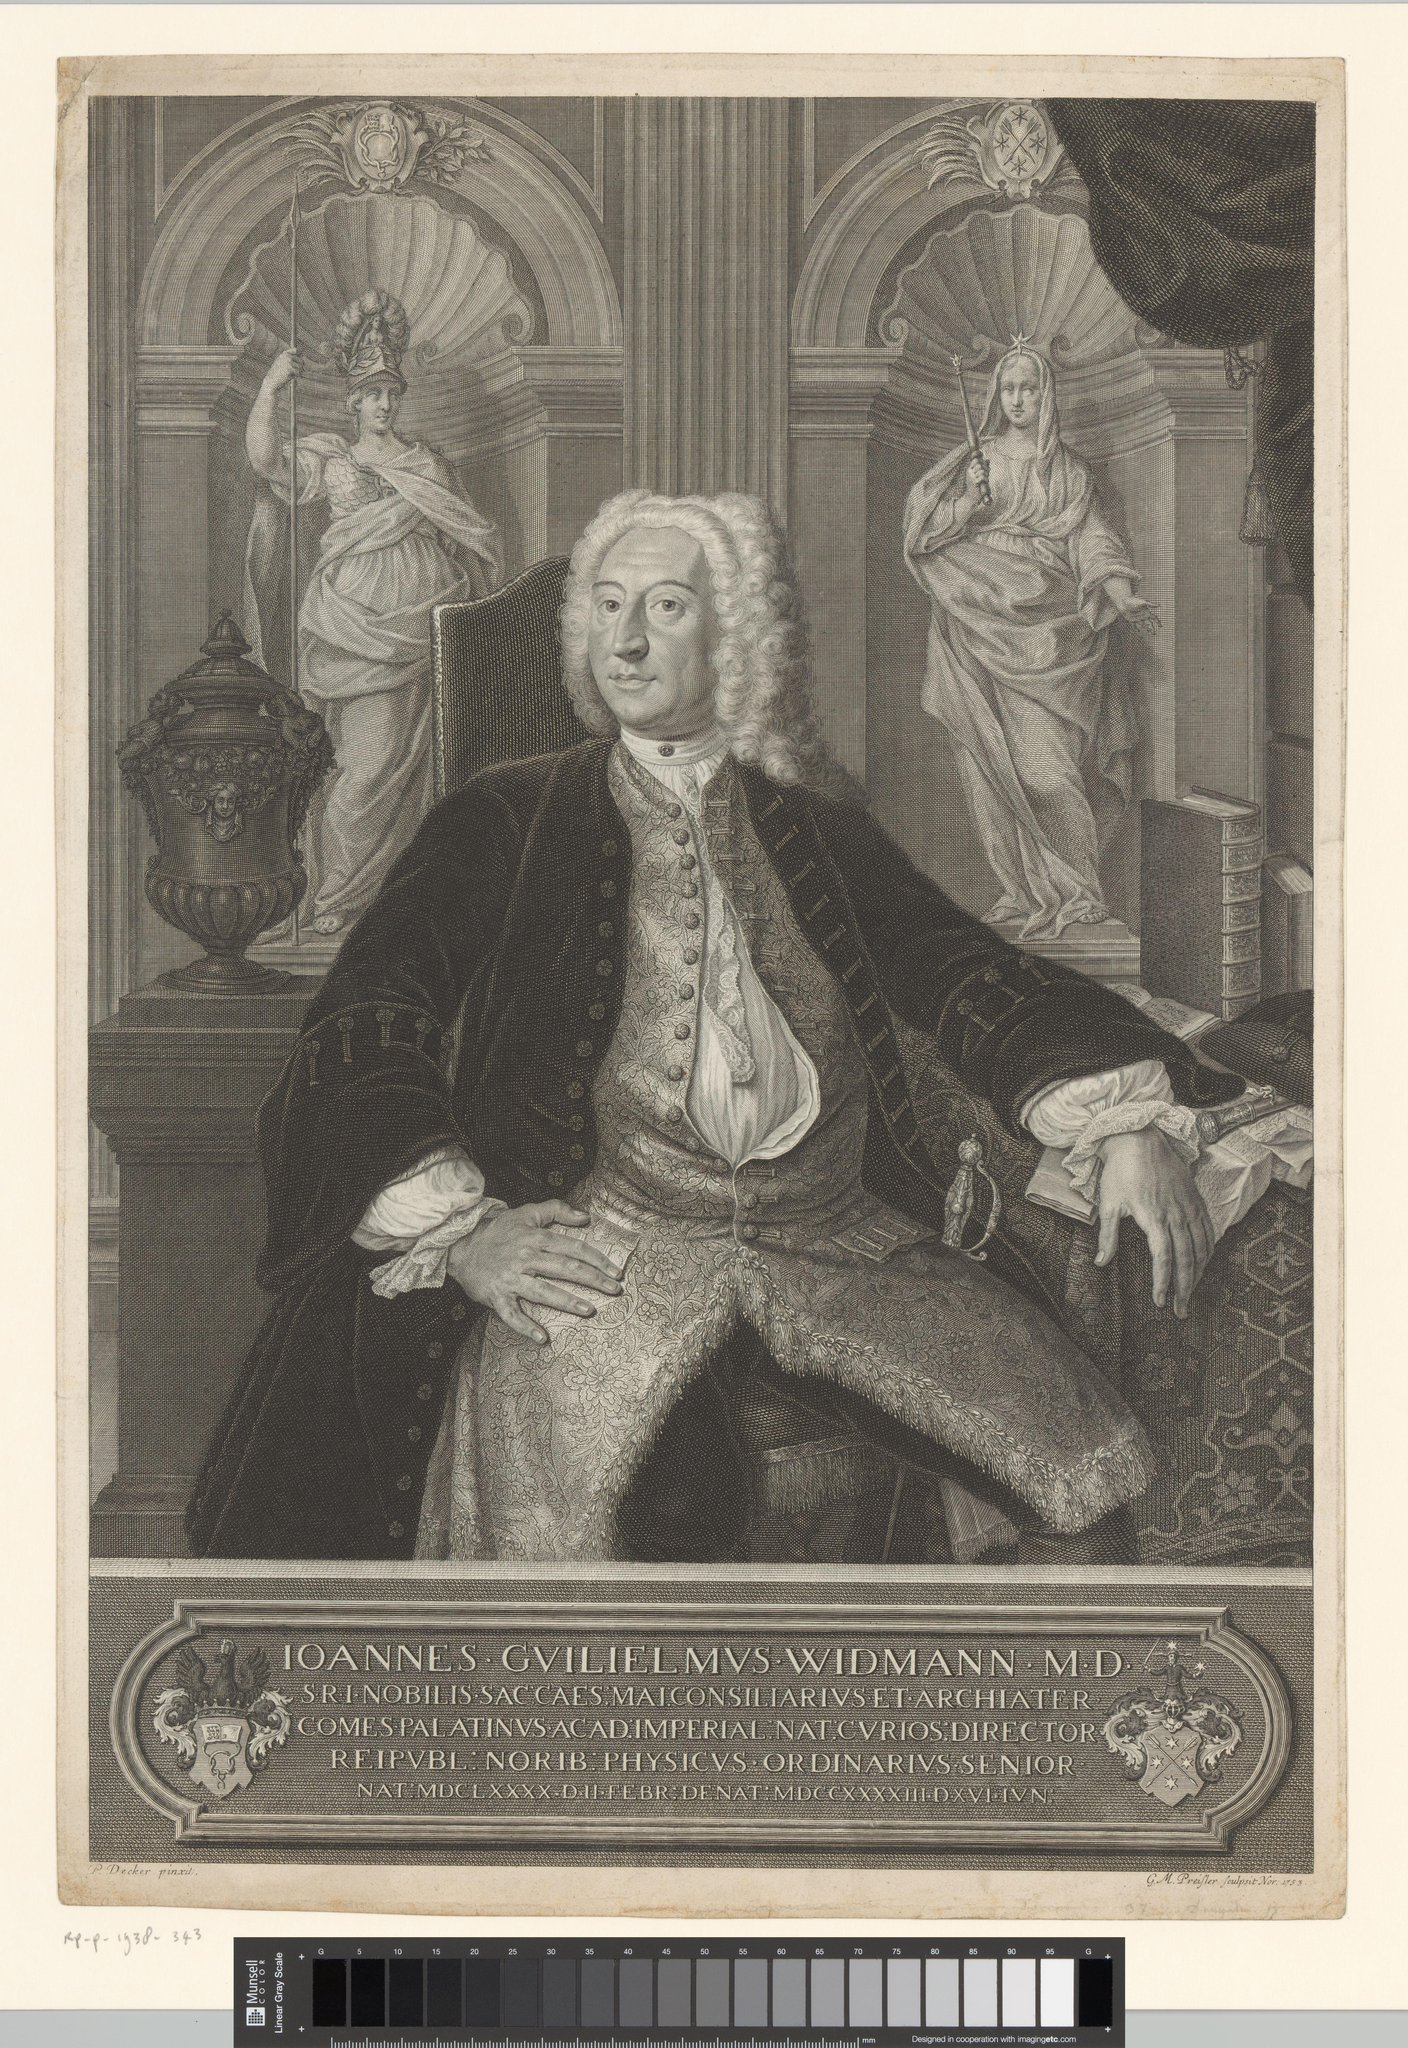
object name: print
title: Portret van Johann Wilhelm Widmann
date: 1753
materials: paper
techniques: engraving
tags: johann wilhelm widmann, walking-stick, staff, vase ~ ornament, historical persons, eternity, 'aeternitas'; 'eternità','eternità o perpetuità' (ripa), hacking and thrusting weapons: sword, specific aspects, allegorical aspects of minerva; minerva as patroness, armorial bearing, heraldry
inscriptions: collector's mark: Lugt 2228